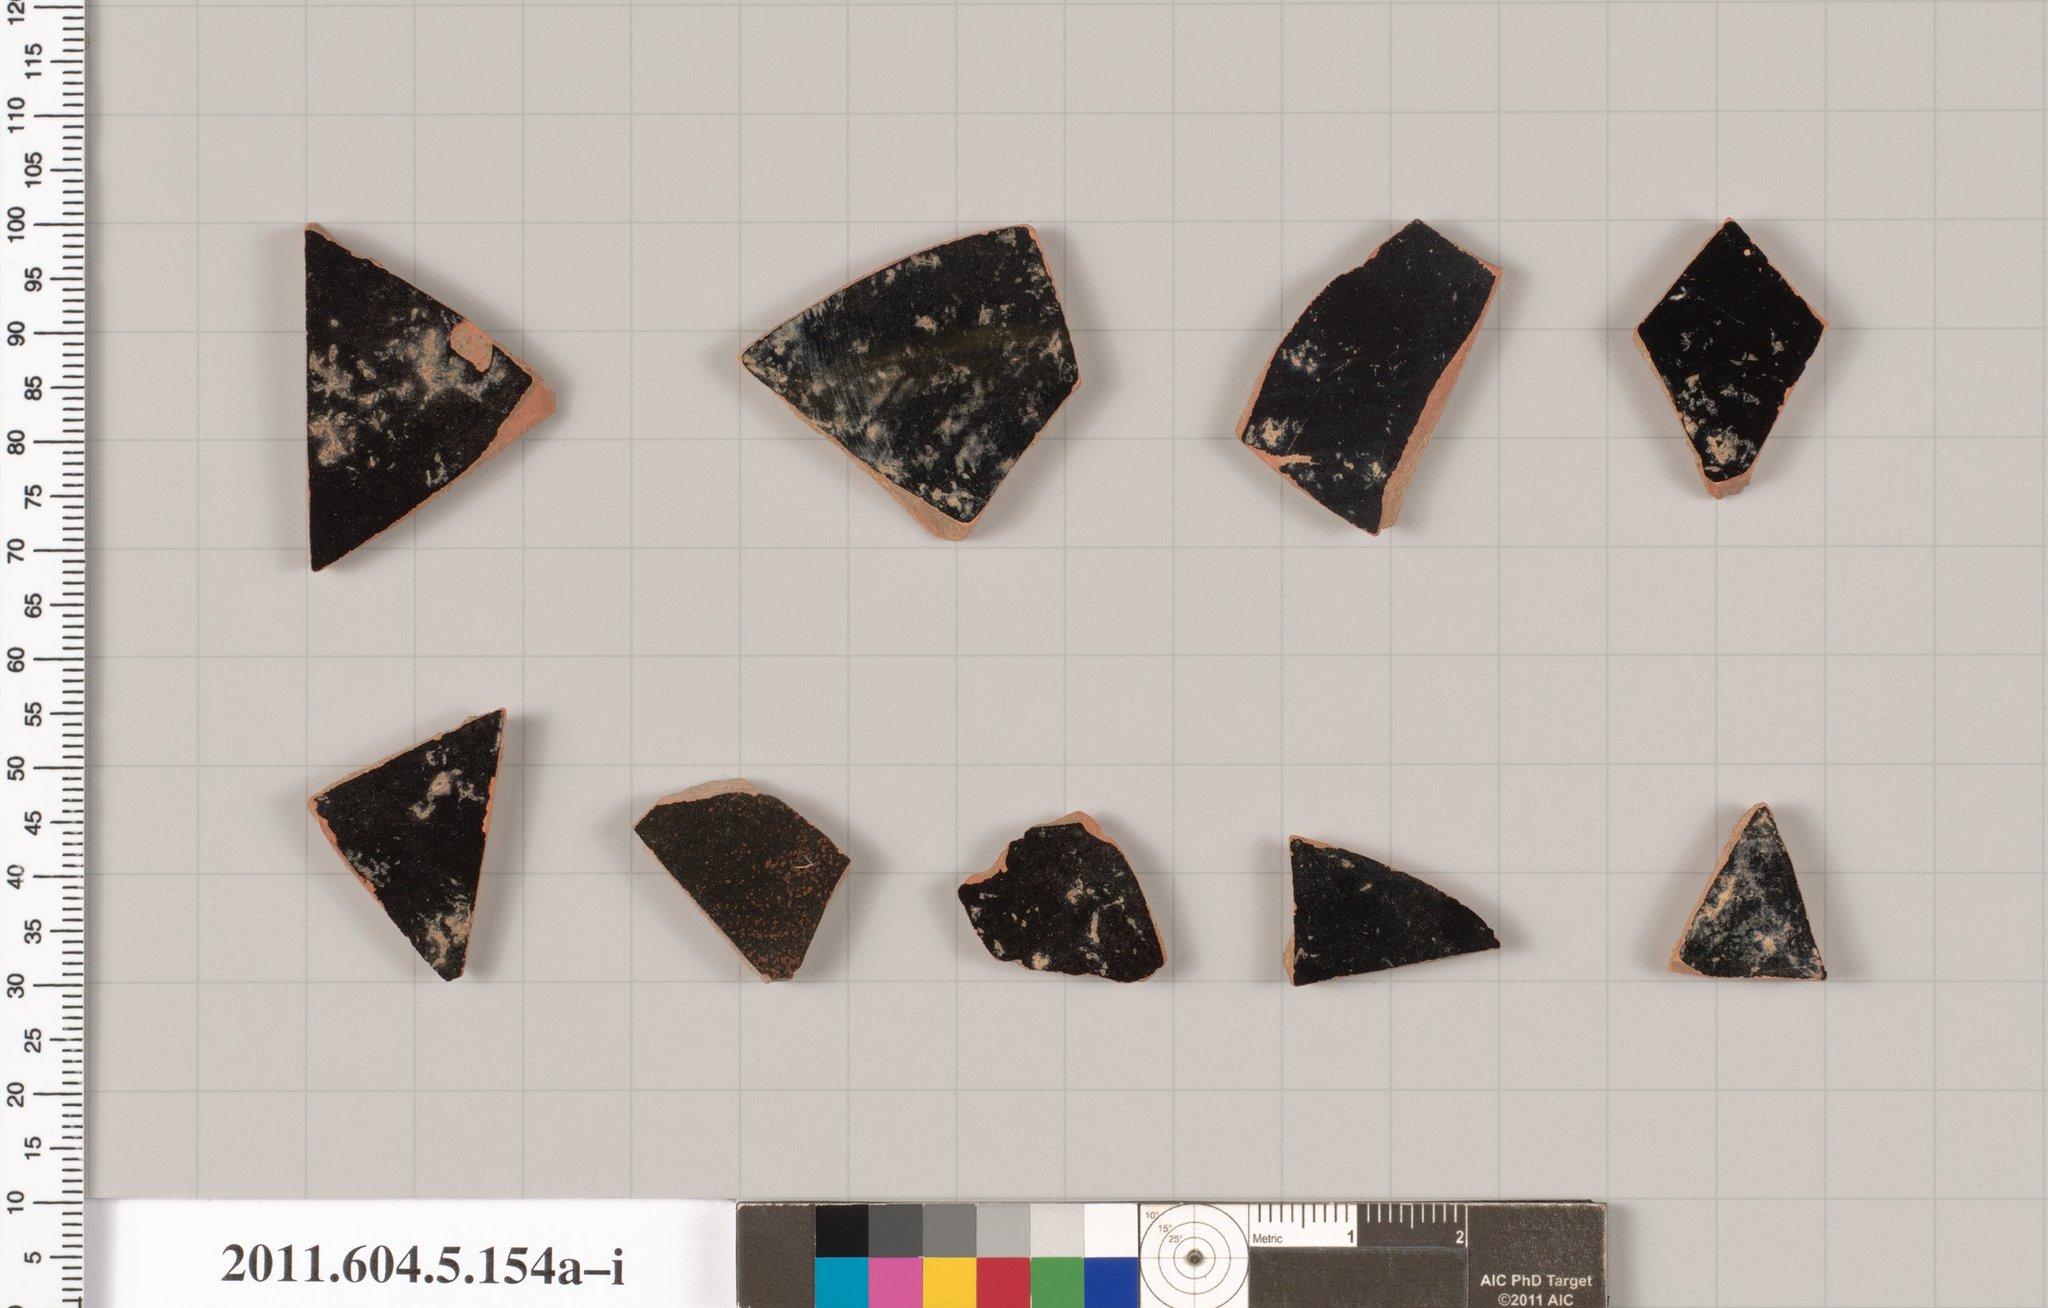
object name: kylix fragment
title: Terracotta fragments of kylikes (drinking cups)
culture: greek, attic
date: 600-401 BCE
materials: terracotta